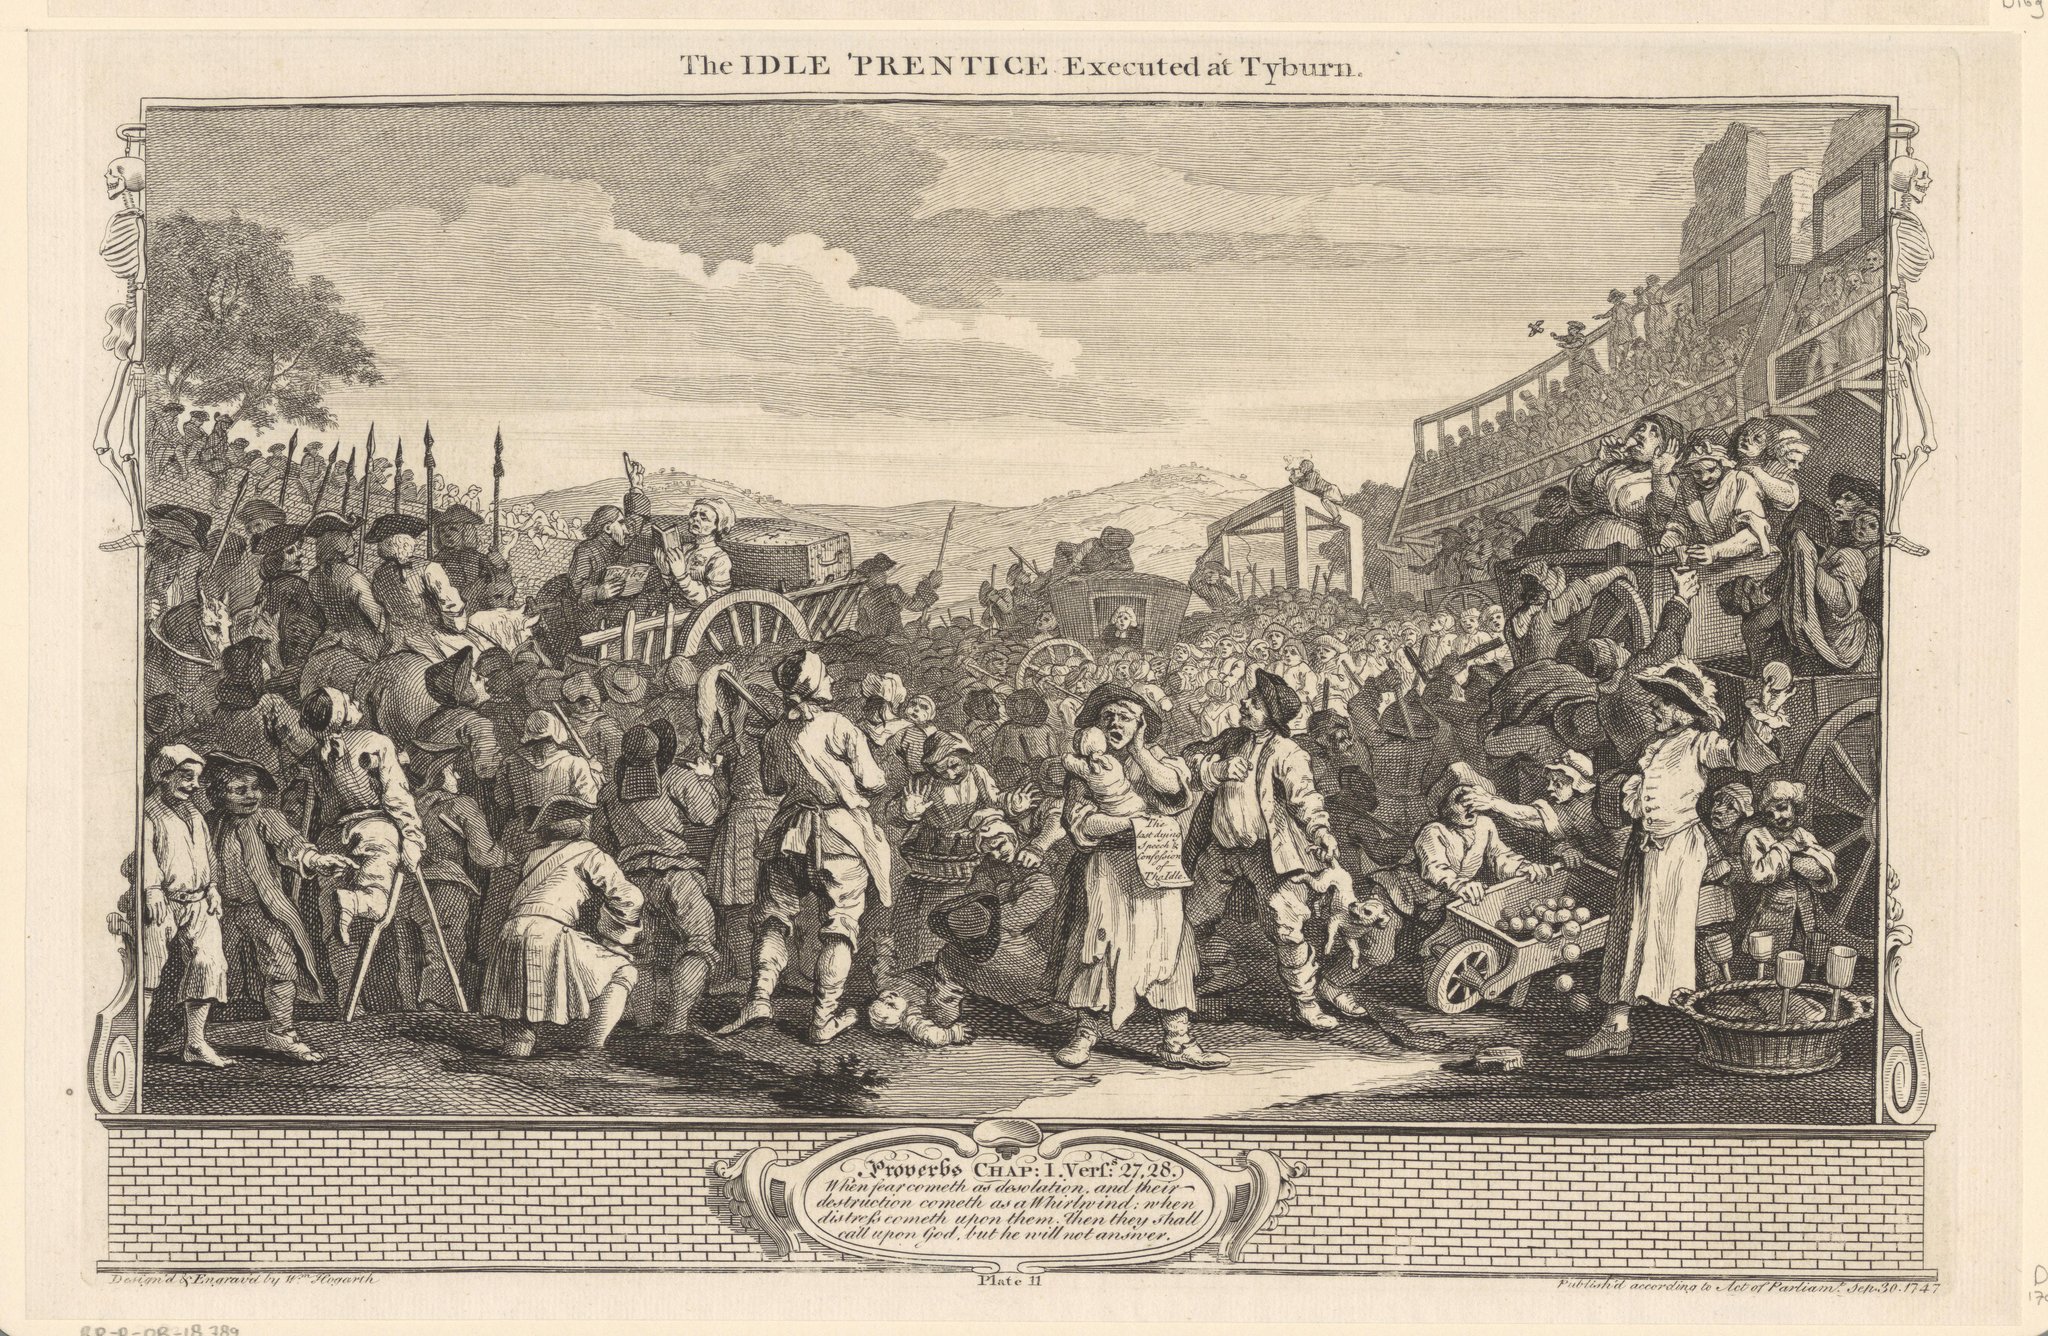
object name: print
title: IJver en luiheid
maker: william hogarth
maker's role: draughtsman, painter, print maker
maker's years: 1697-1764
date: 1709-1747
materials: paper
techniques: etching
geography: london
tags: instruments of torture, execution or punishment: gallows, death penalty, execution, coffin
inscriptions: date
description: De serie van twaalf platen illustreert (de gevolgen van) luiheid en onverantwoordelijkheid enerzijds en hard werken anderzijds. Onder de prent staat steeds een Bijbels citaat.